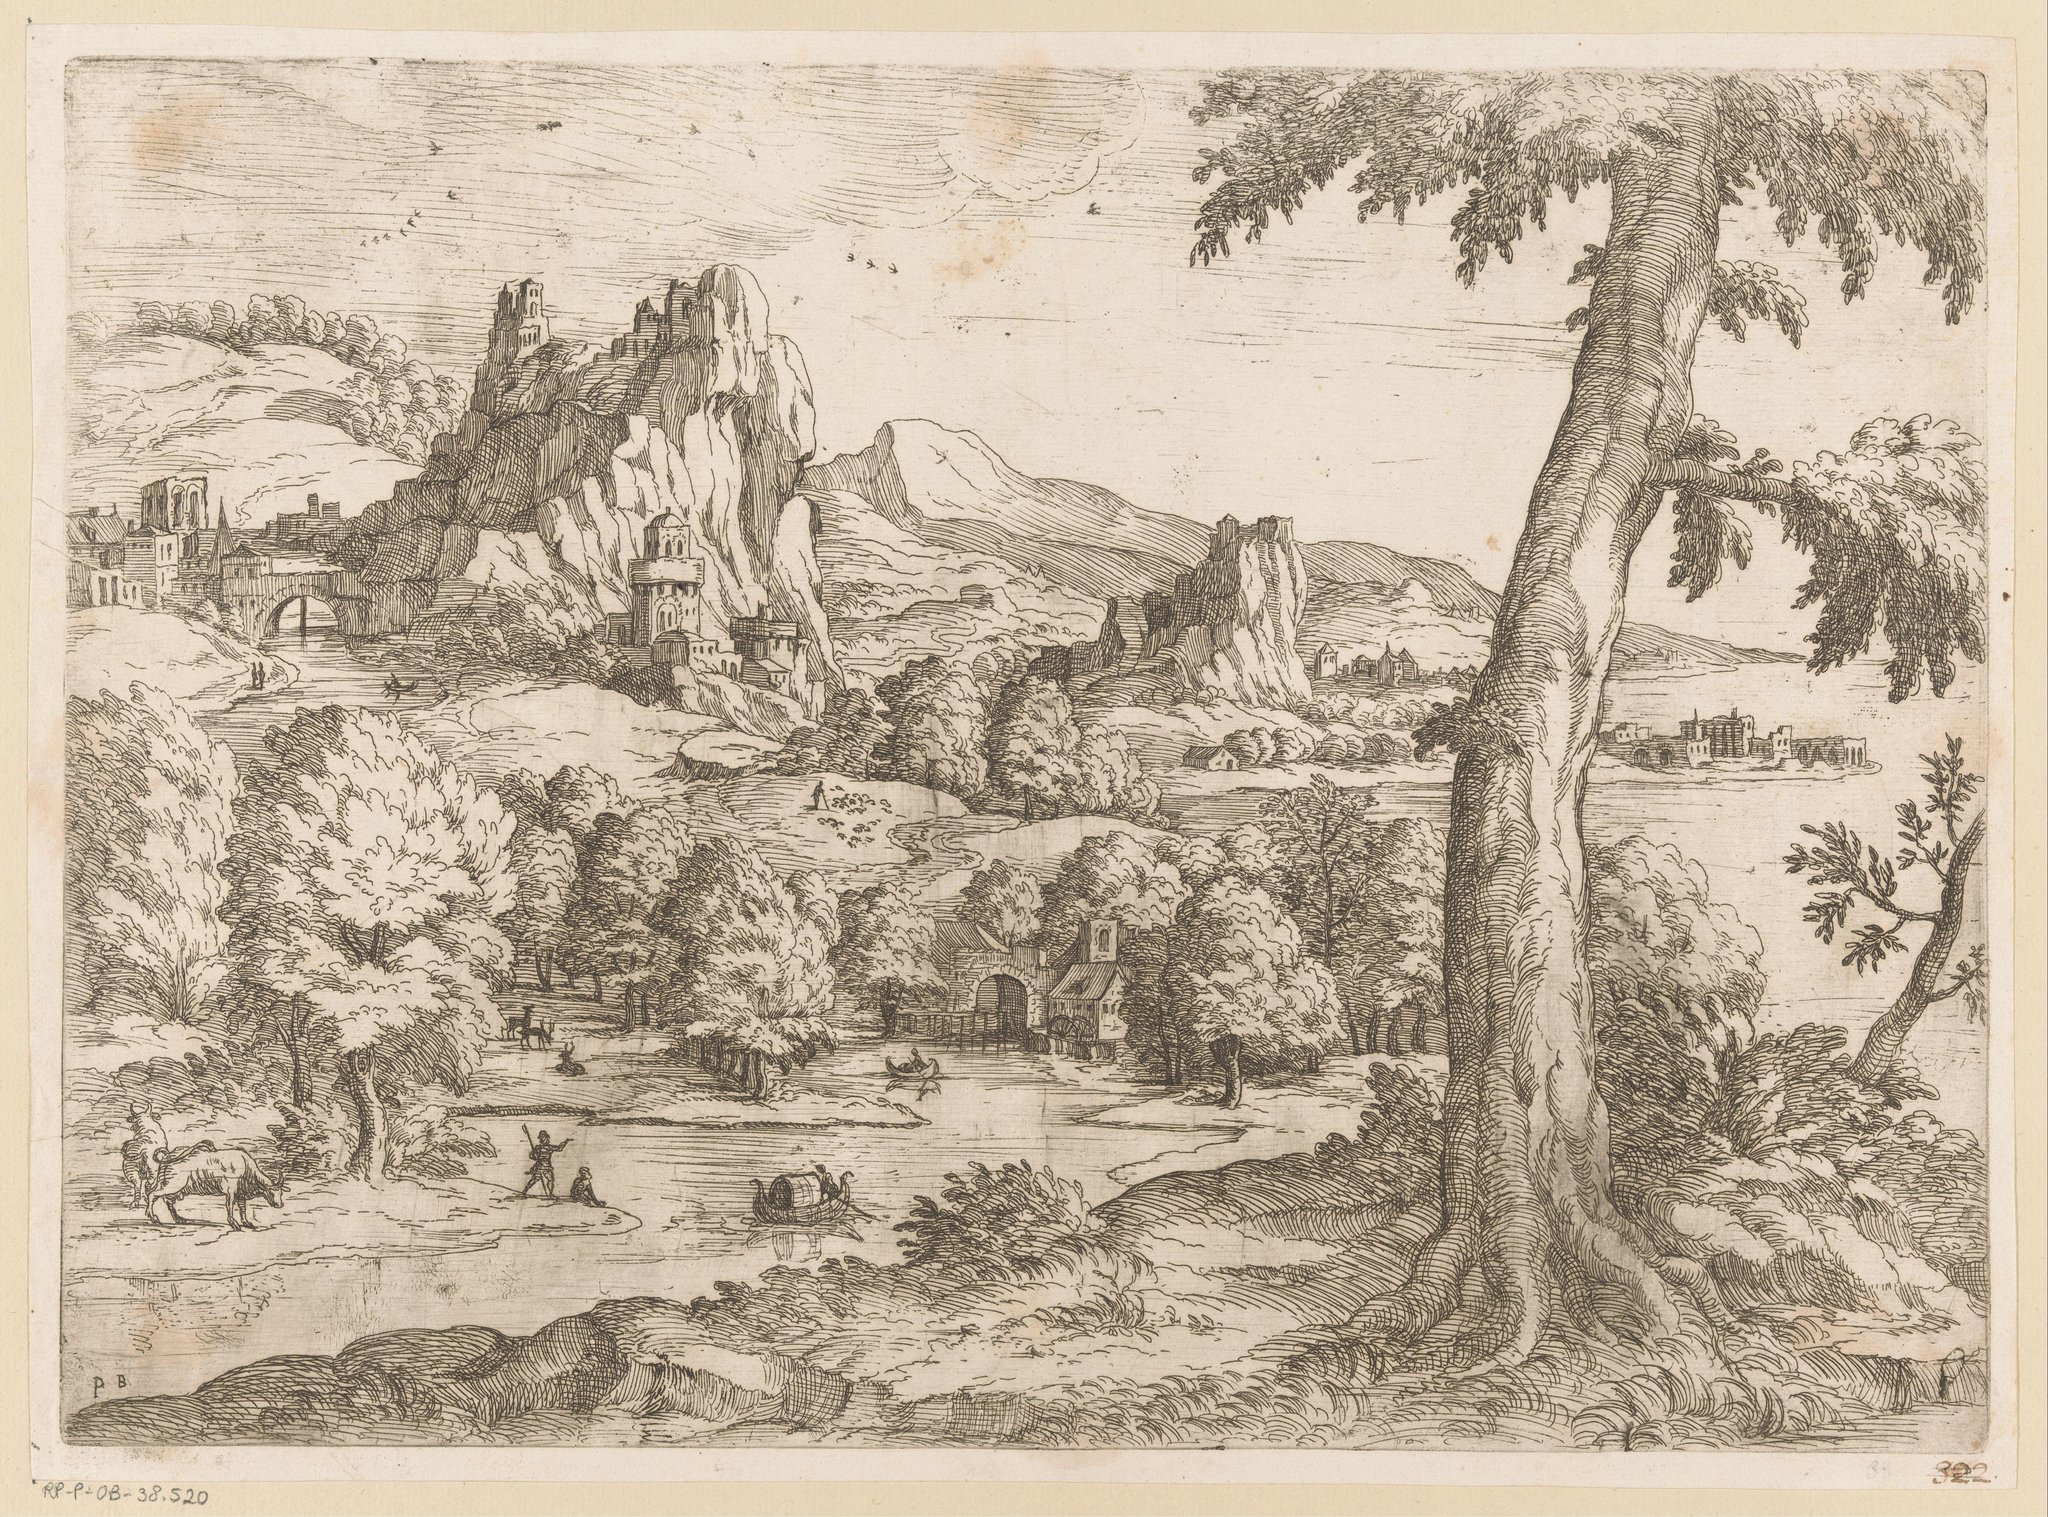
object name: print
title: Rivierlandschap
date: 1500-1599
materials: paper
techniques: etching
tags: fortress, landscapes, river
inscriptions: collector's mark: Lugt 240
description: Heuvellandschap waar een rivier doorheen kronkelt. Op de voorgrond rechts een boom. Op de achtergrond links een fort op een heuvel en rechts de kust.